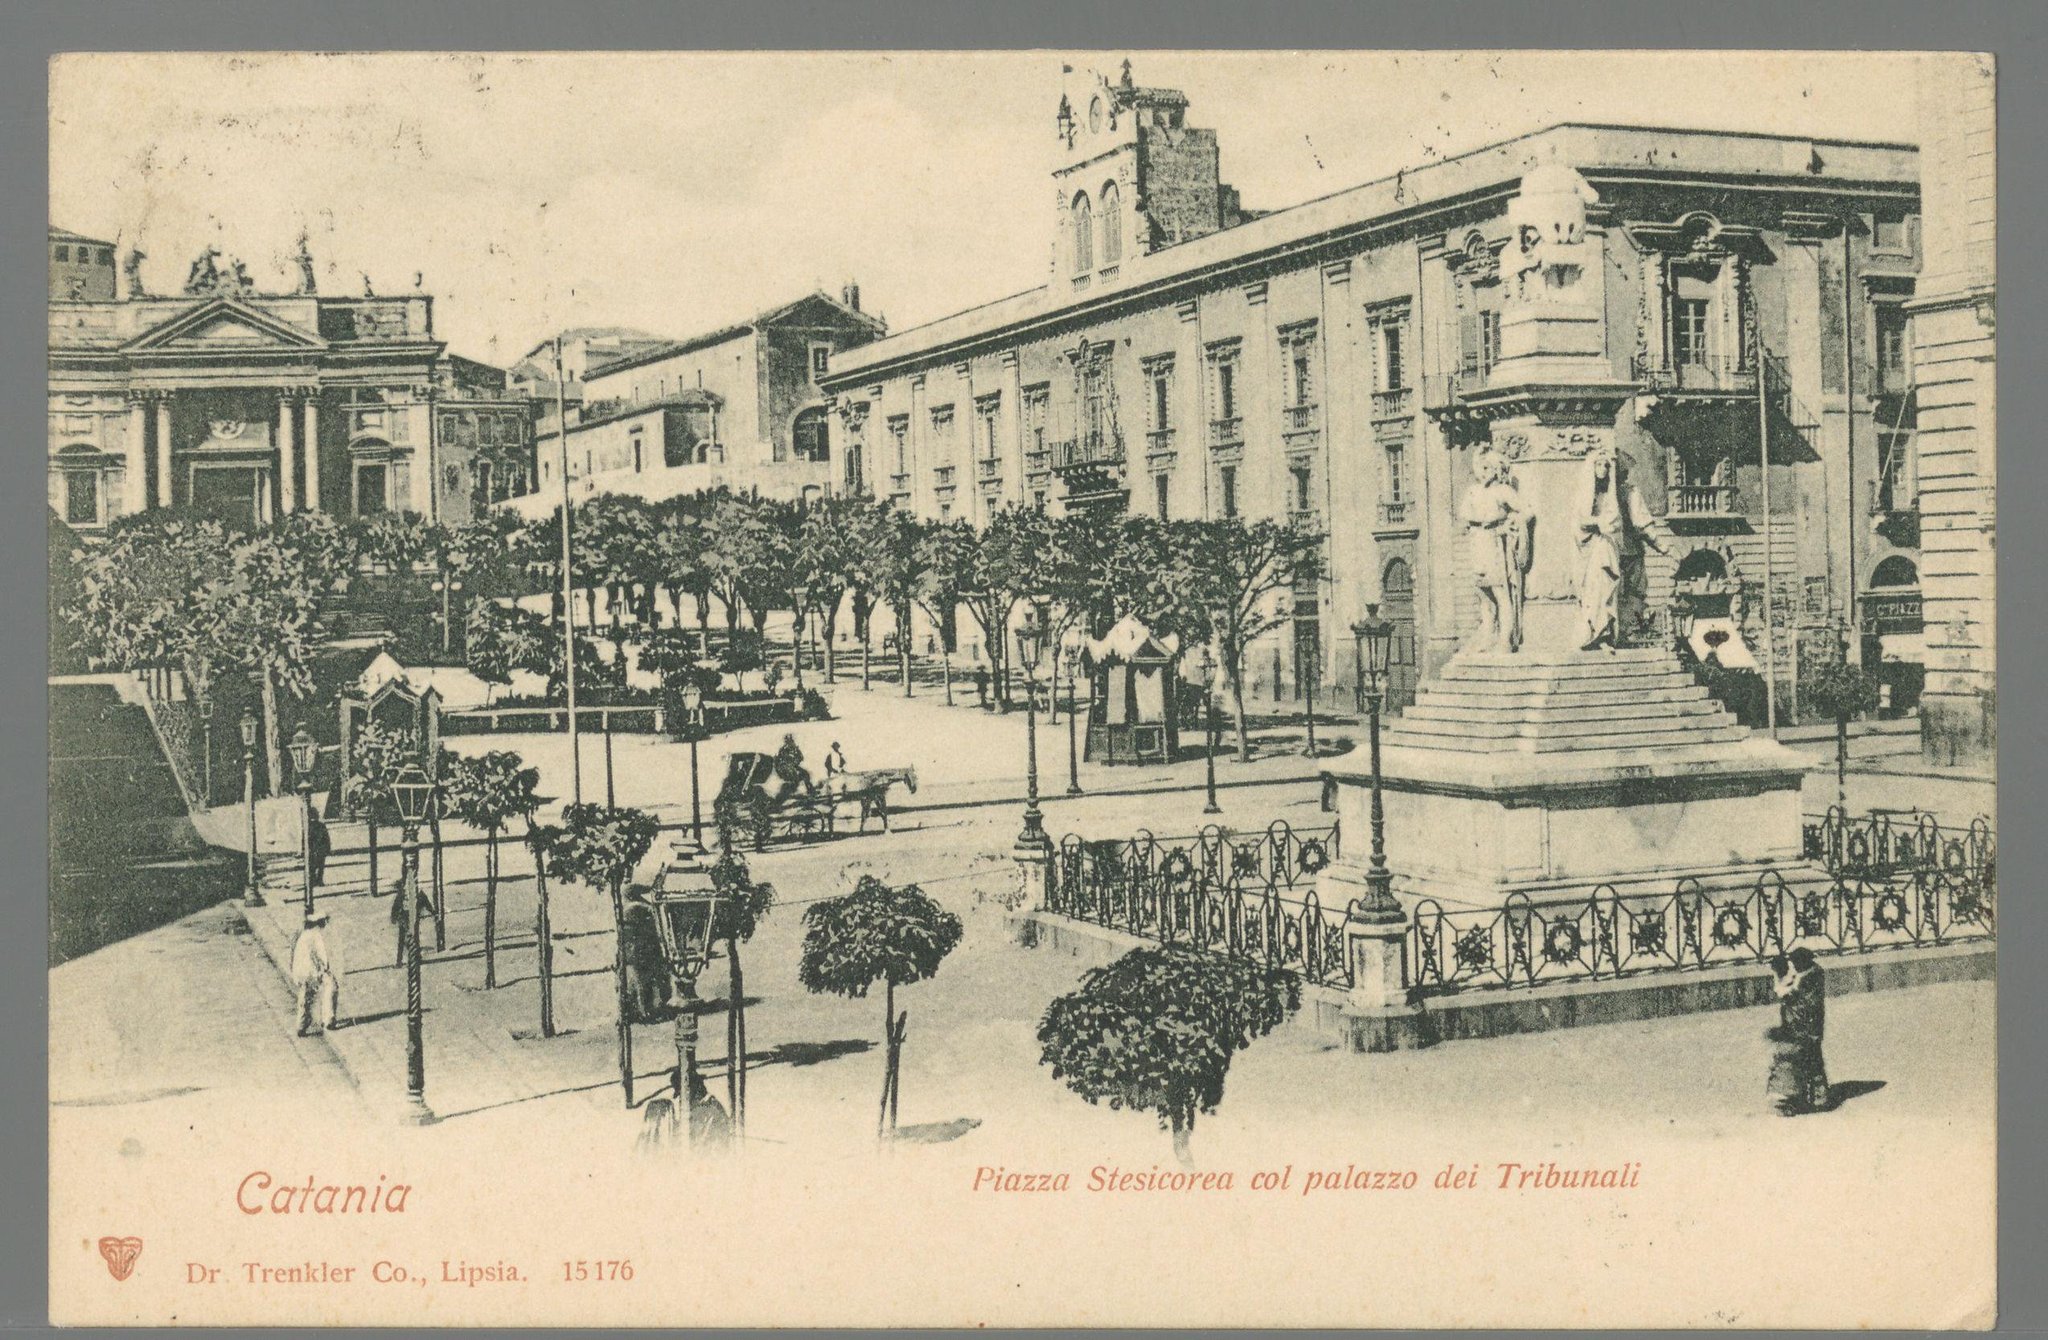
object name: photomechanical print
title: Catania. Piazza Stesicorea col palazzo dei Tribunali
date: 1885-1903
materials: cardboard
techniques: photograph, writing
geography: catania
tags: court building, square, place, circus, etc. (+ city(-scape) with figures, staffage)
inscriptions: postage stamp